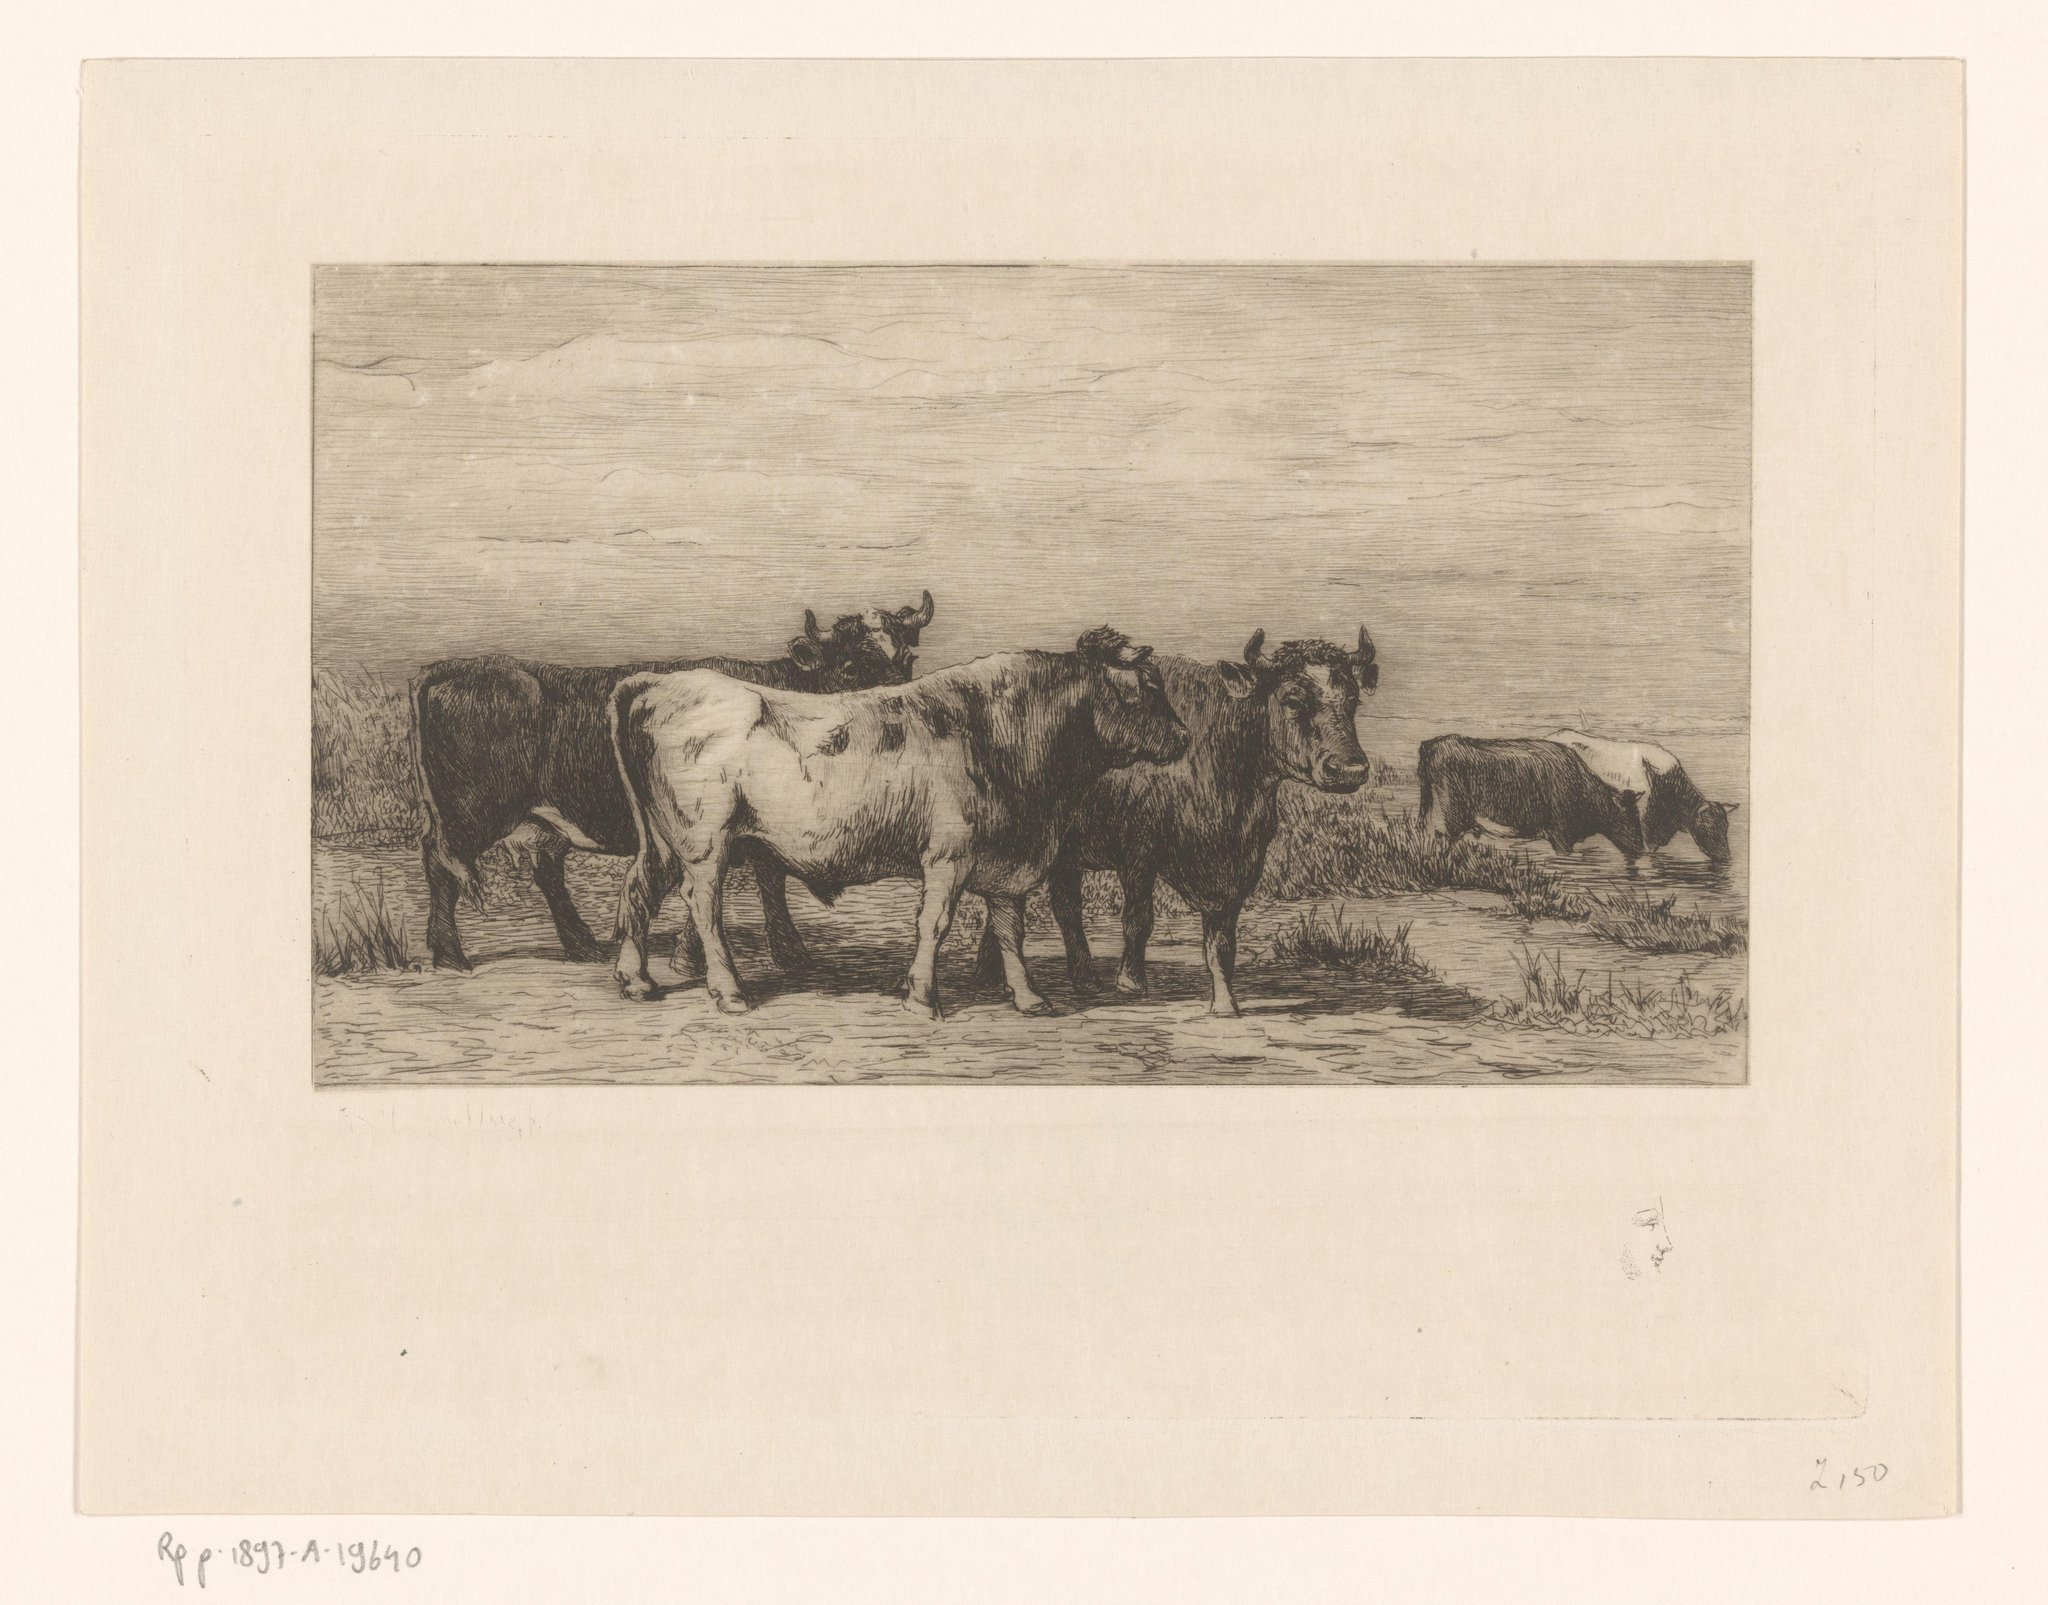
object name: print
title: Landschap met vee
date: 1867-1890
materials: paper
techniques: drypoint, etching, intaglio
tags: bovine cattle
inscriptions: collector's mark: Lugt 2228